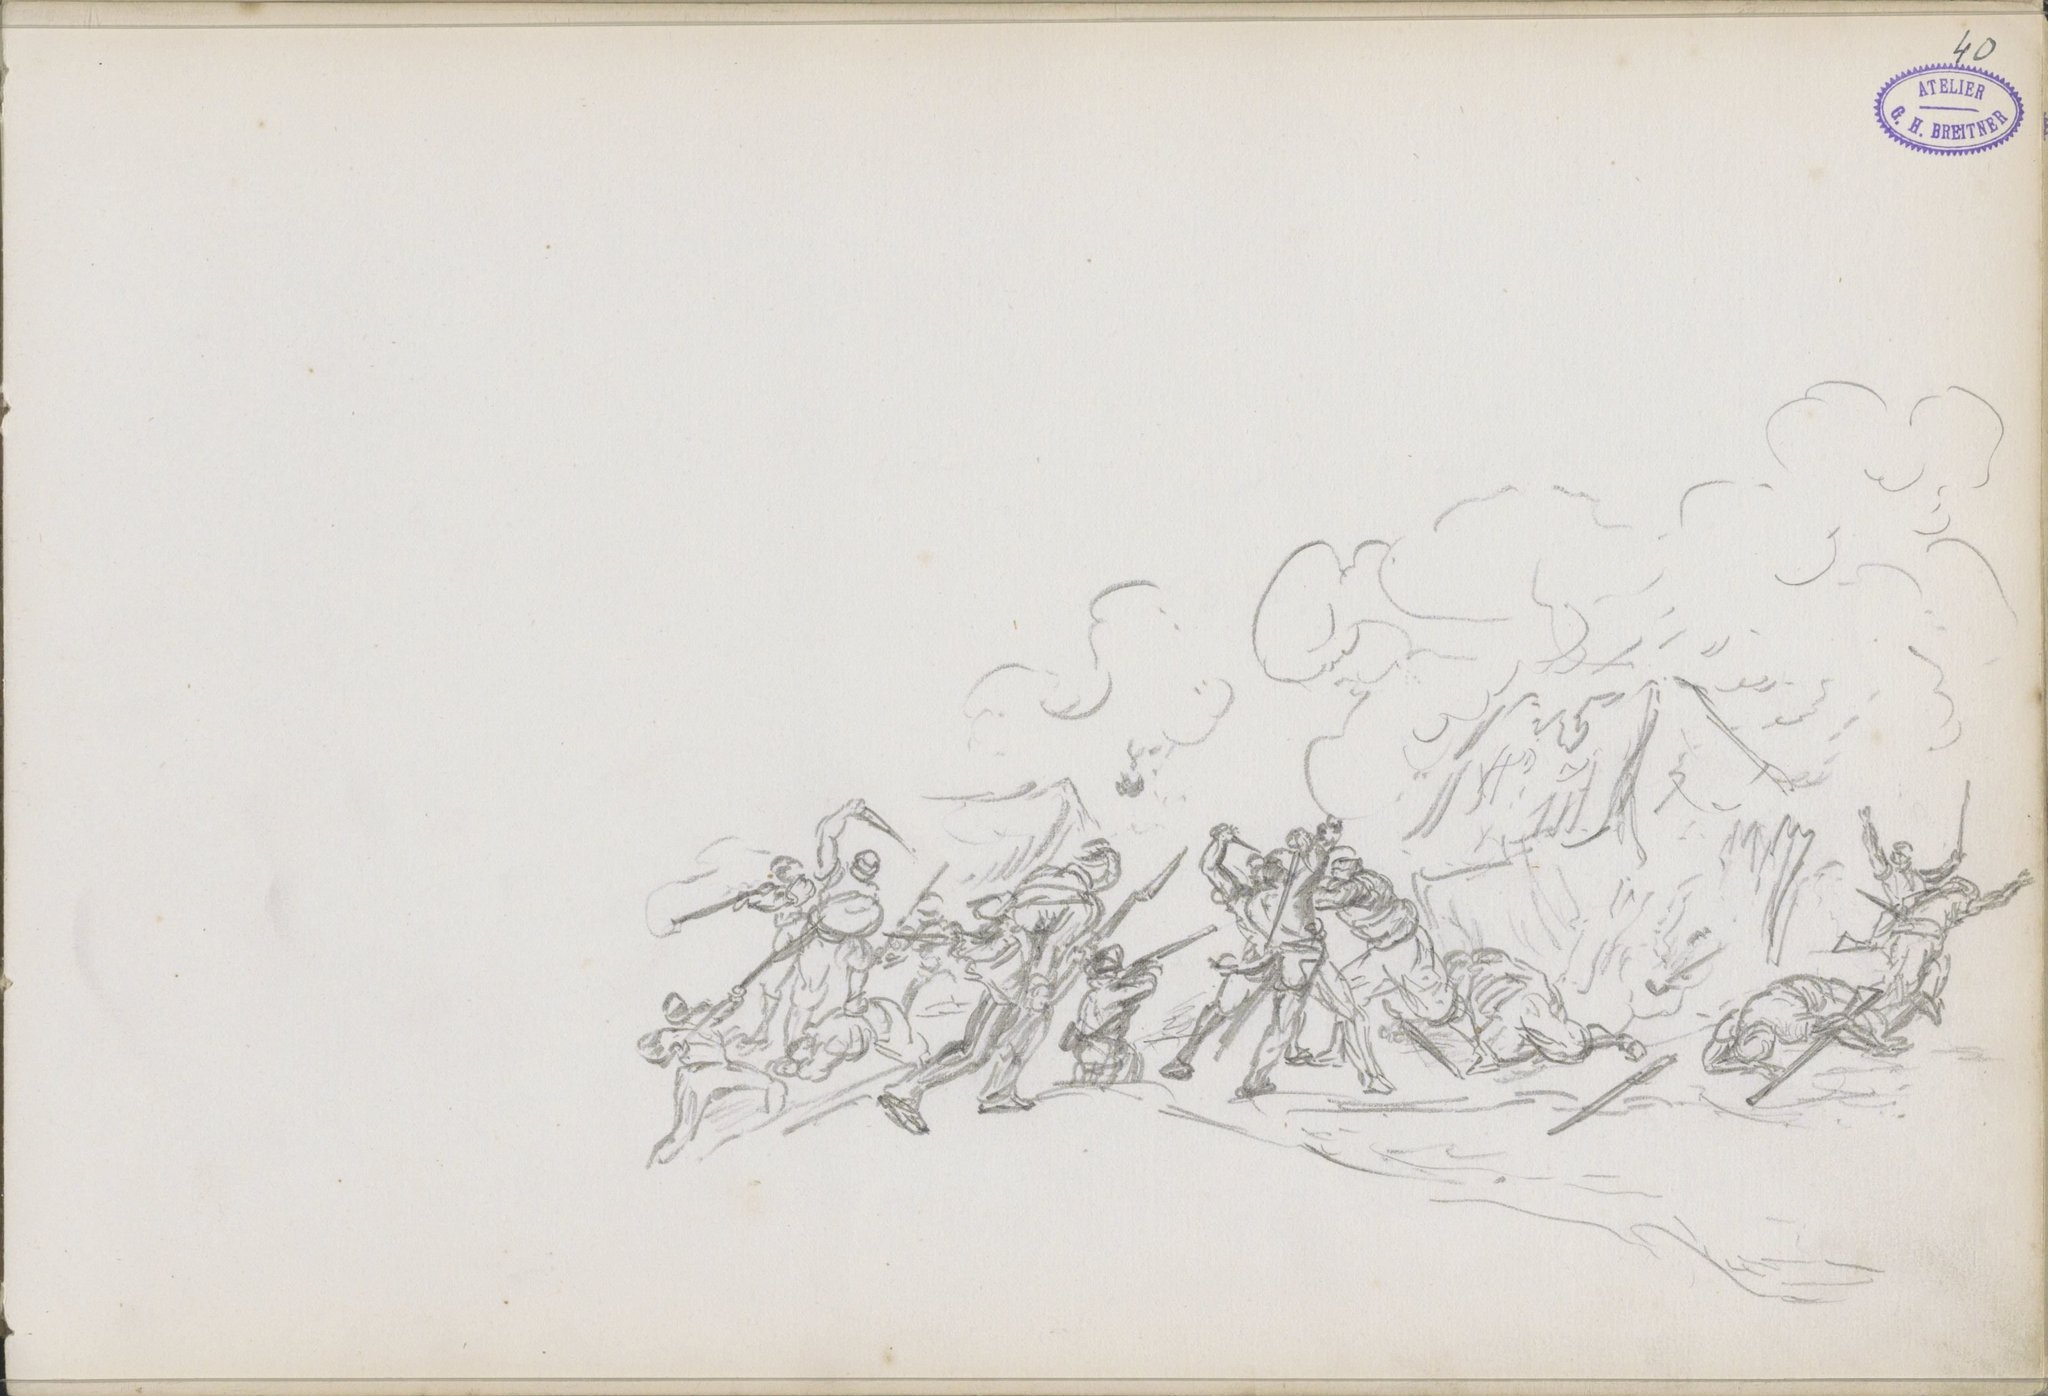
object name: sketchbook leaf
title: Strijdende soldaten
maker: george hendrik breitner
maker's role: draughtsman, painter, print maker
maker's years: 1857-1923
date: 1809-1872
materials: paper, pencil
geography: rotterdam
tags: division of armed forces (+ during the battle), division of armed forces (+ infantry)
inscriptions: workshop stamp: Lugt 291d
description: Blad 40 uit een schetsboek met 32 bladen.